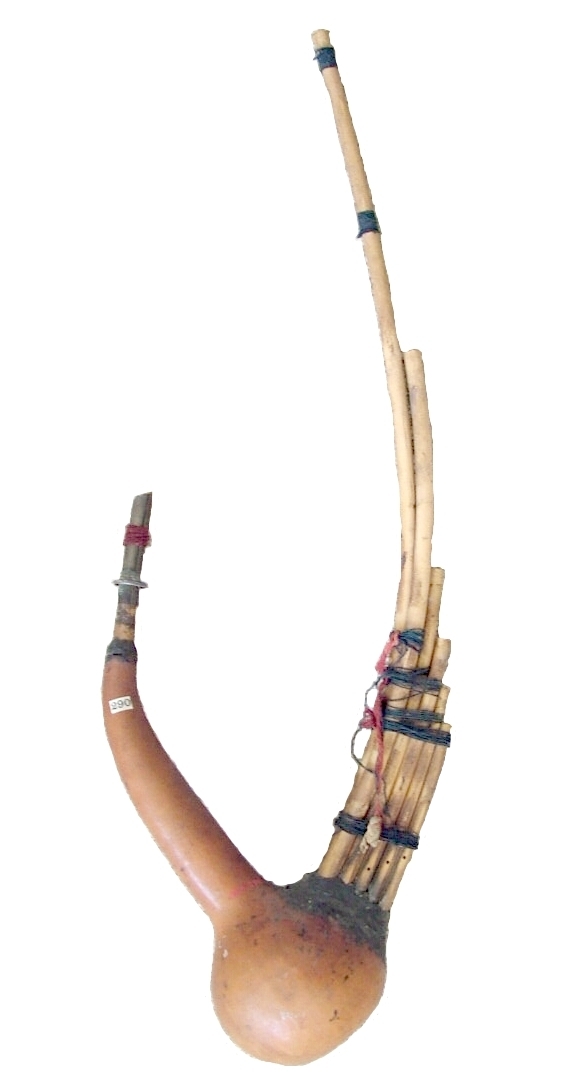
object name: hnyìn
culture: burmese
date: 1867-1900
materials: bamboo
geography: myanmar